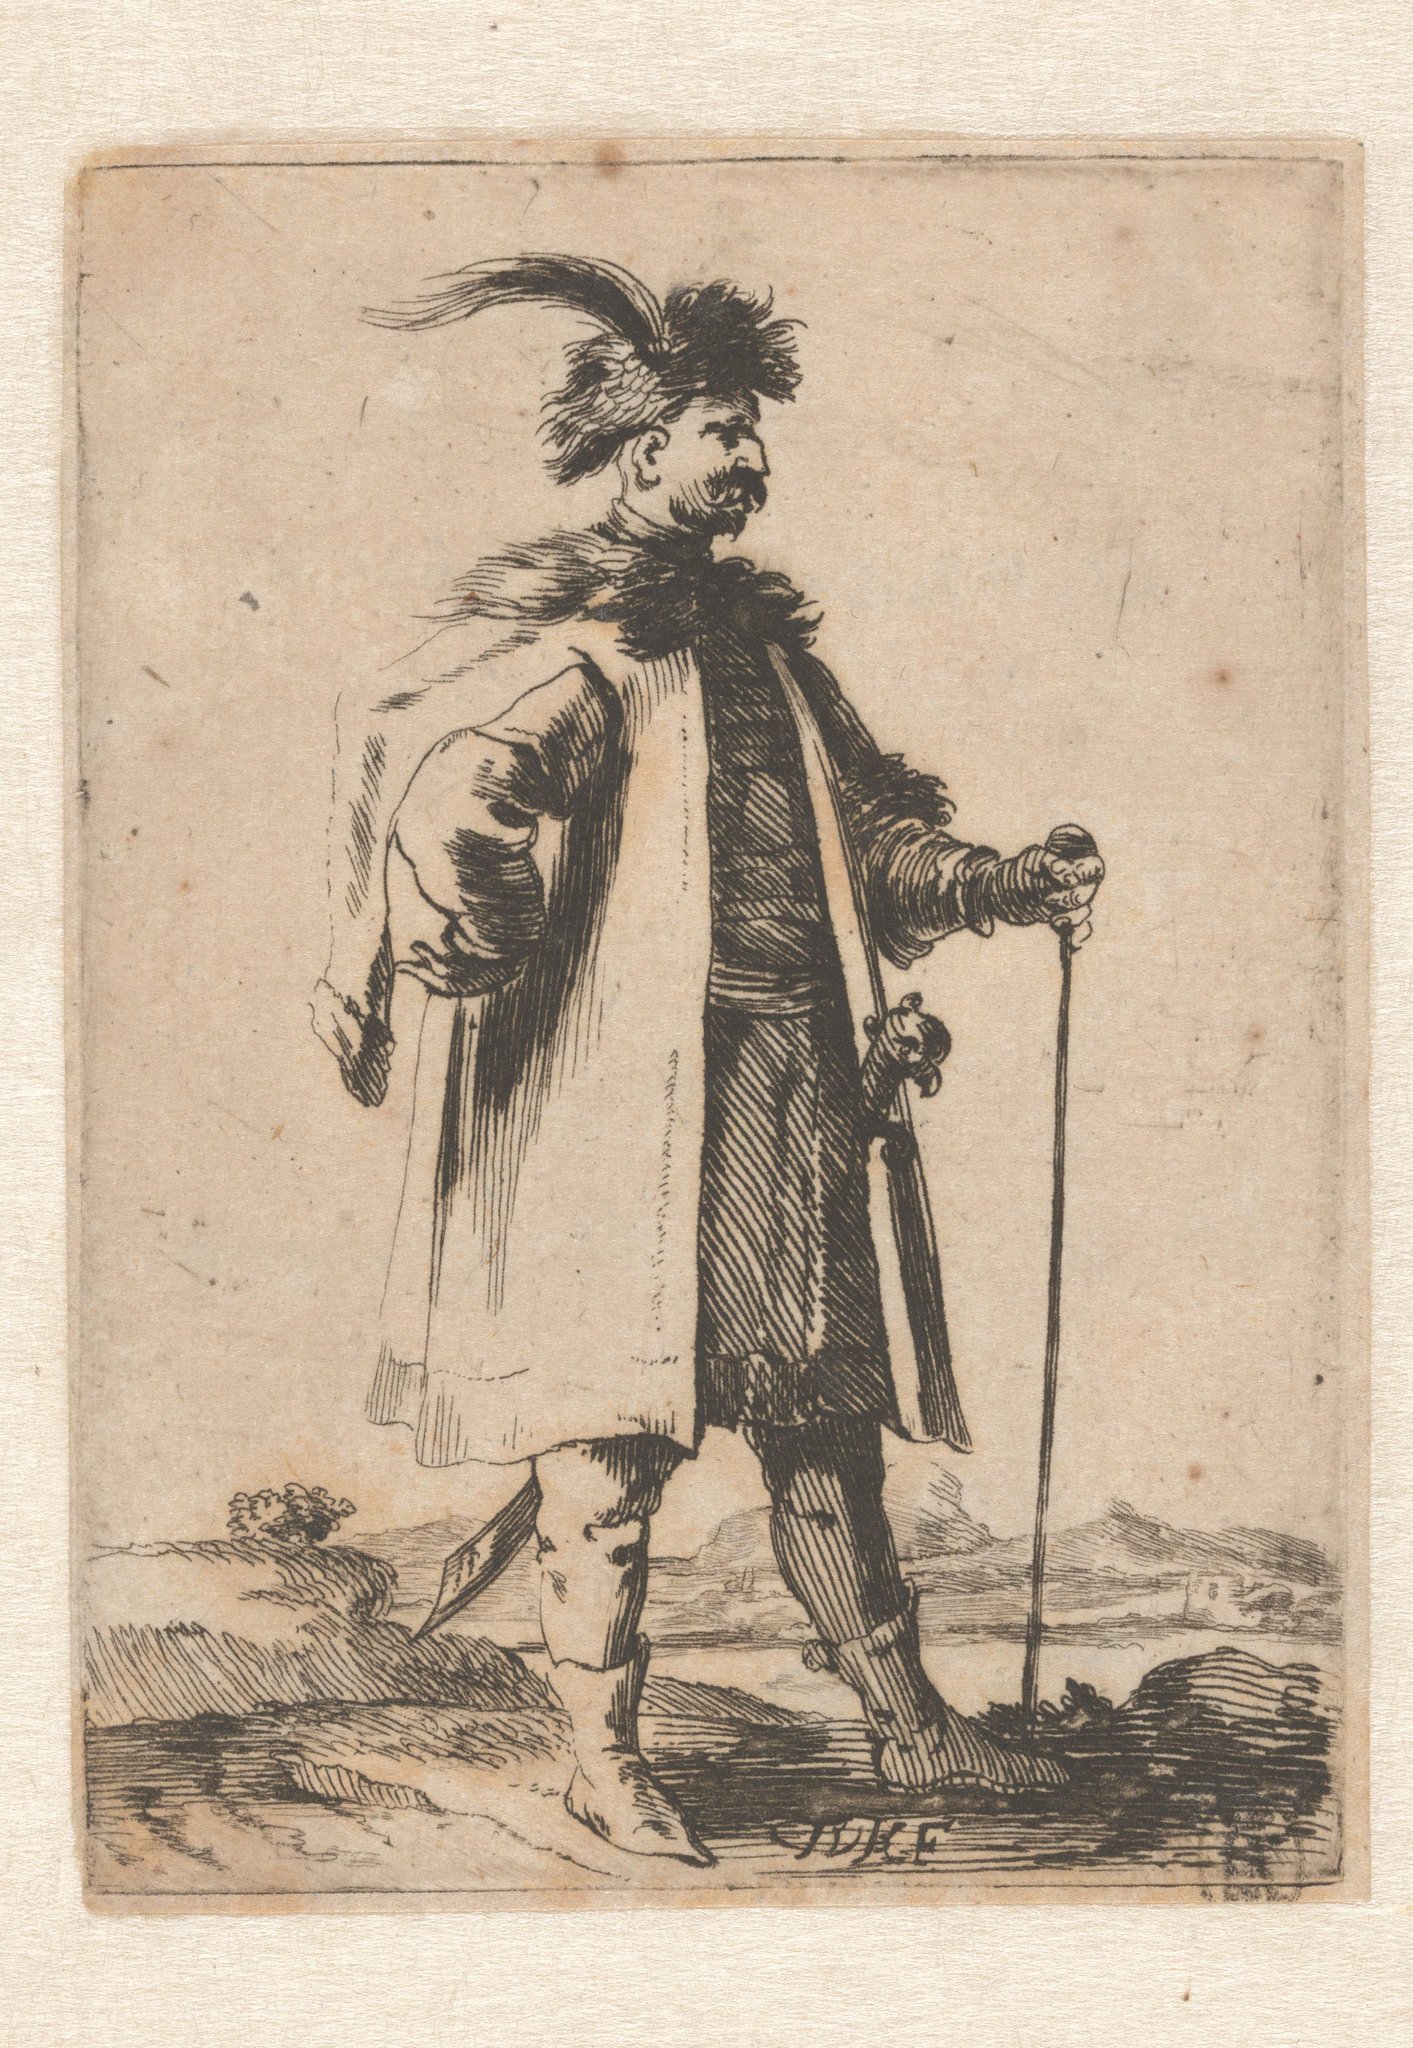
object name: print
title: Oosterling met gevederde hoed en zwaard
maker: theodorus van kessel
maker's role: print maker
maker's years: 1620-1660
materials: paper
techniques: etching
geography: low countries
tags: asiatic races and peoples, head-gear: cap (+ feathers used for clothes)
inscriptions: collector's mark: Lugt 2228, collector's mark: Lugt 2760